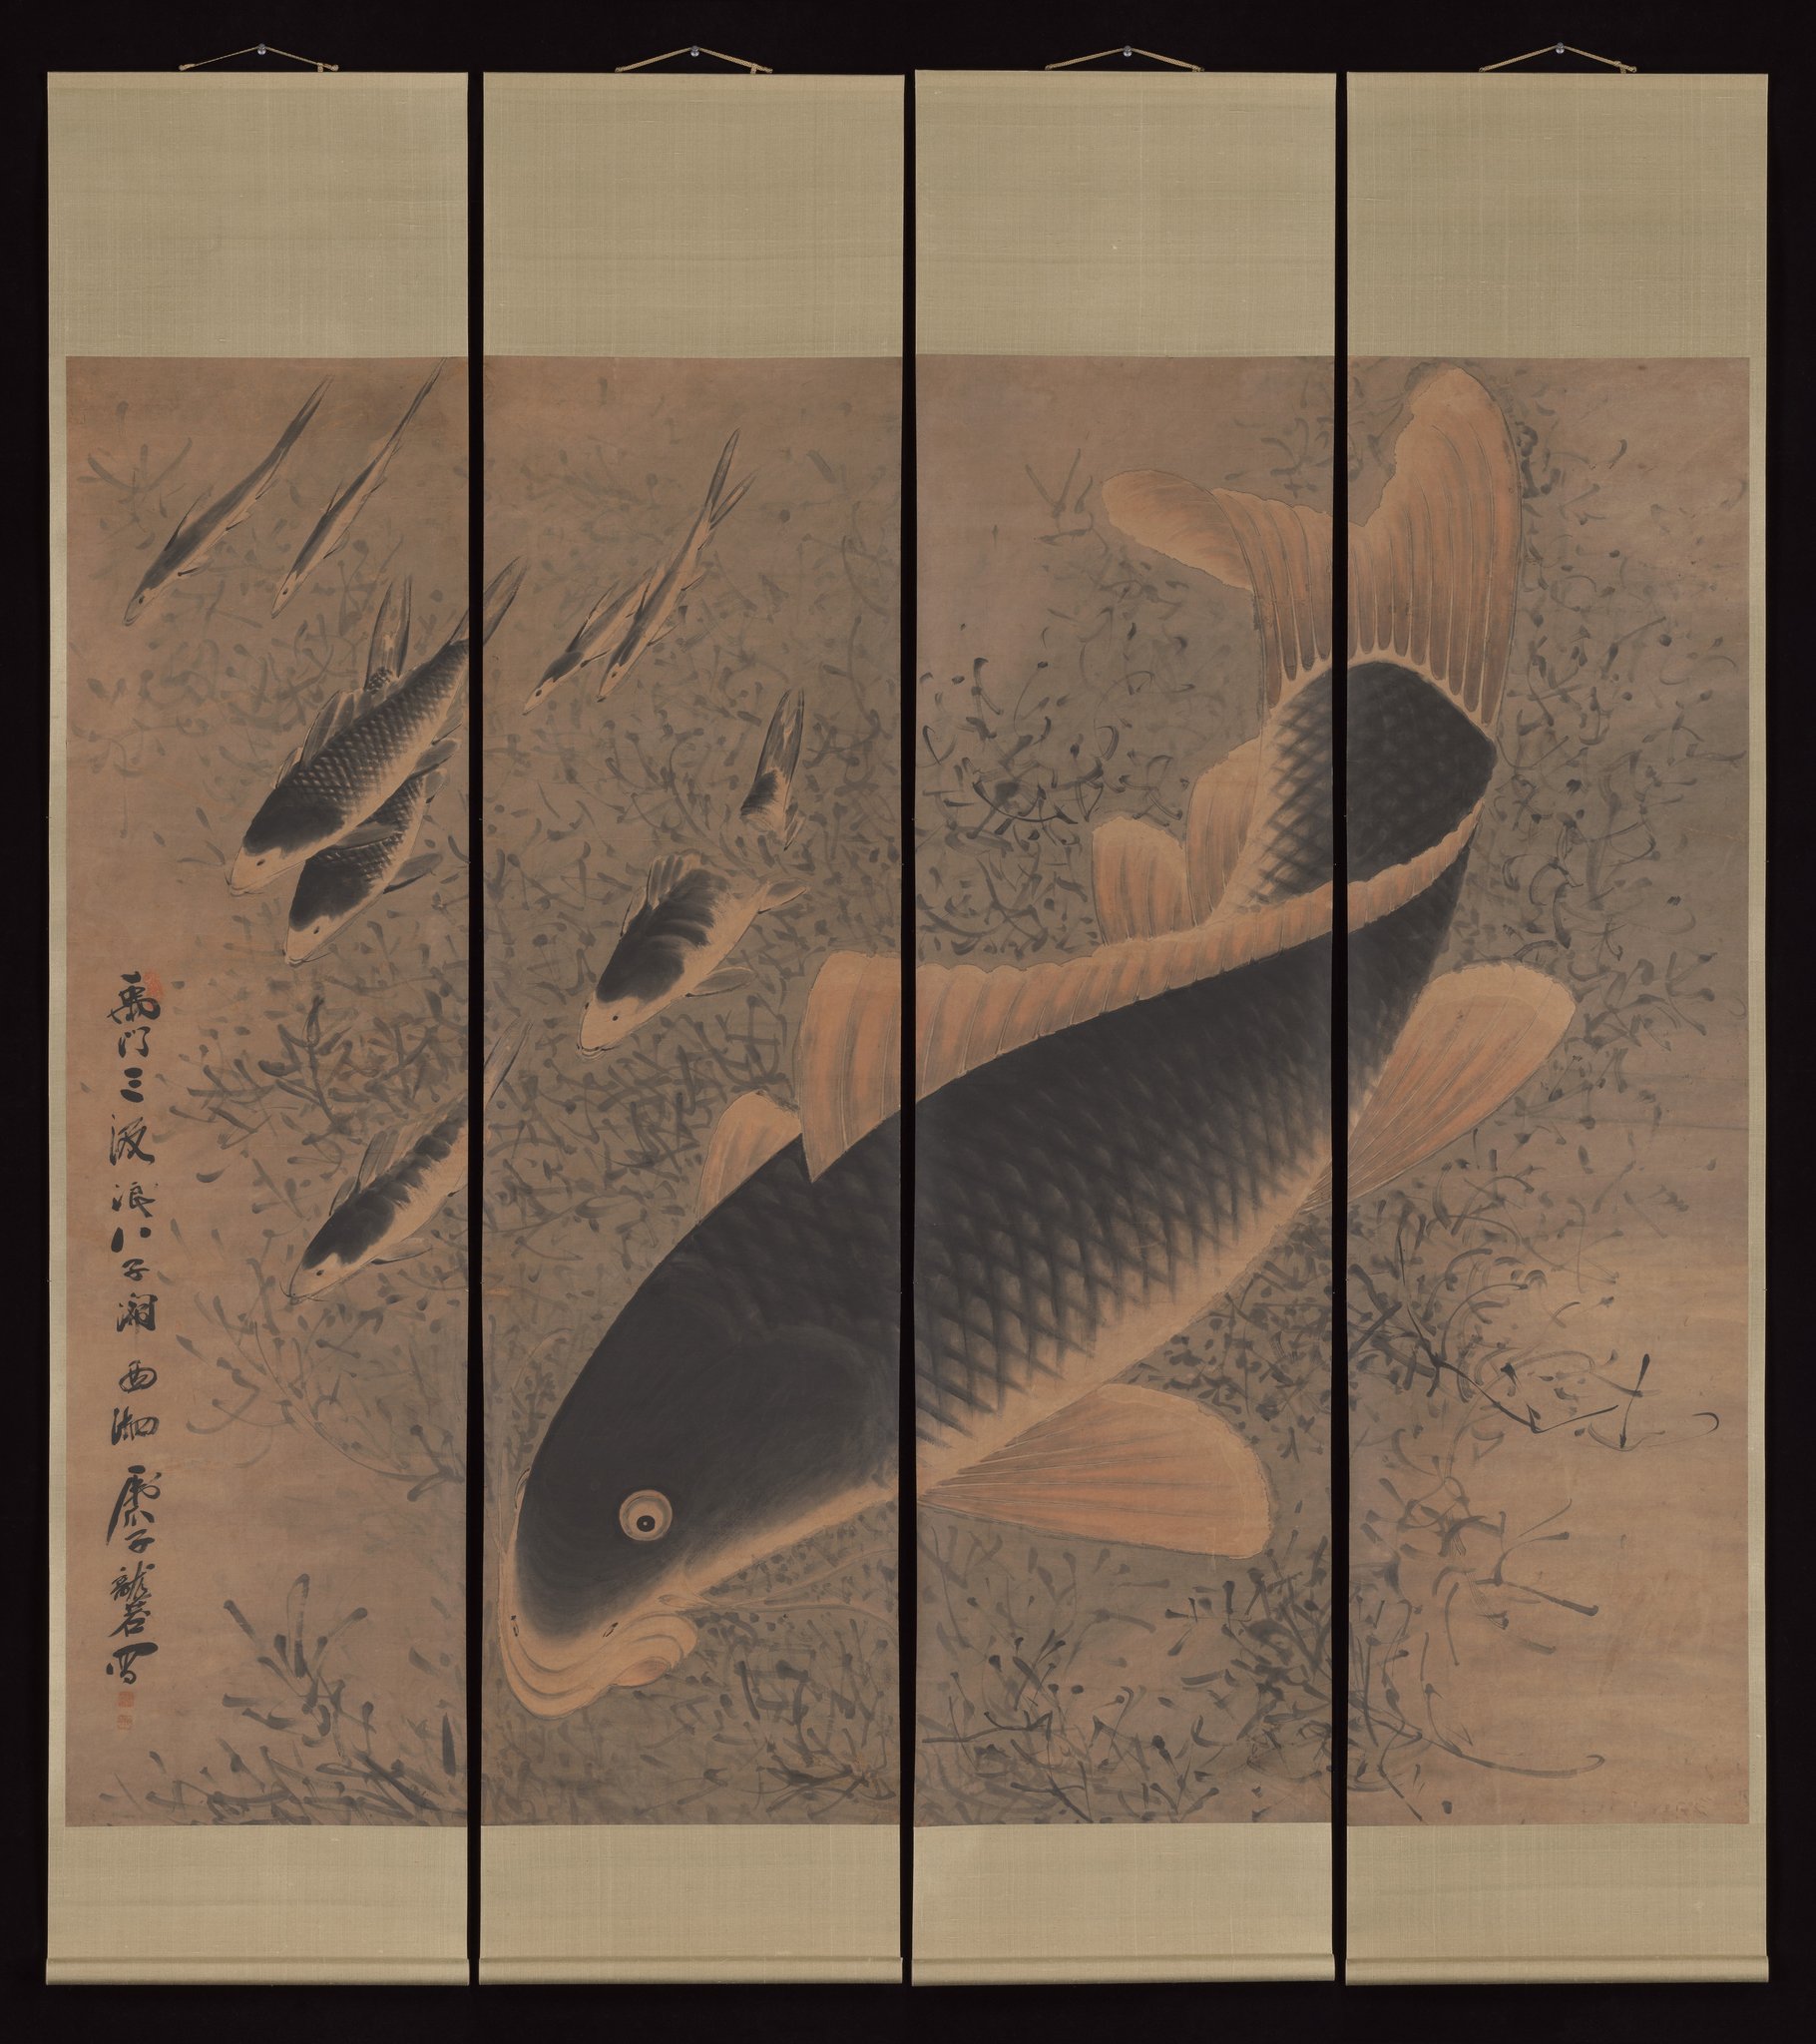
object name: hanging scroll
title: Nine carp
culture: chinese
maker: gong gu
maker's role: artist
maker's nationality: chinese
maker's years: 1700-1899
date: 1801-1900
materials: ink, paper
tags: fish